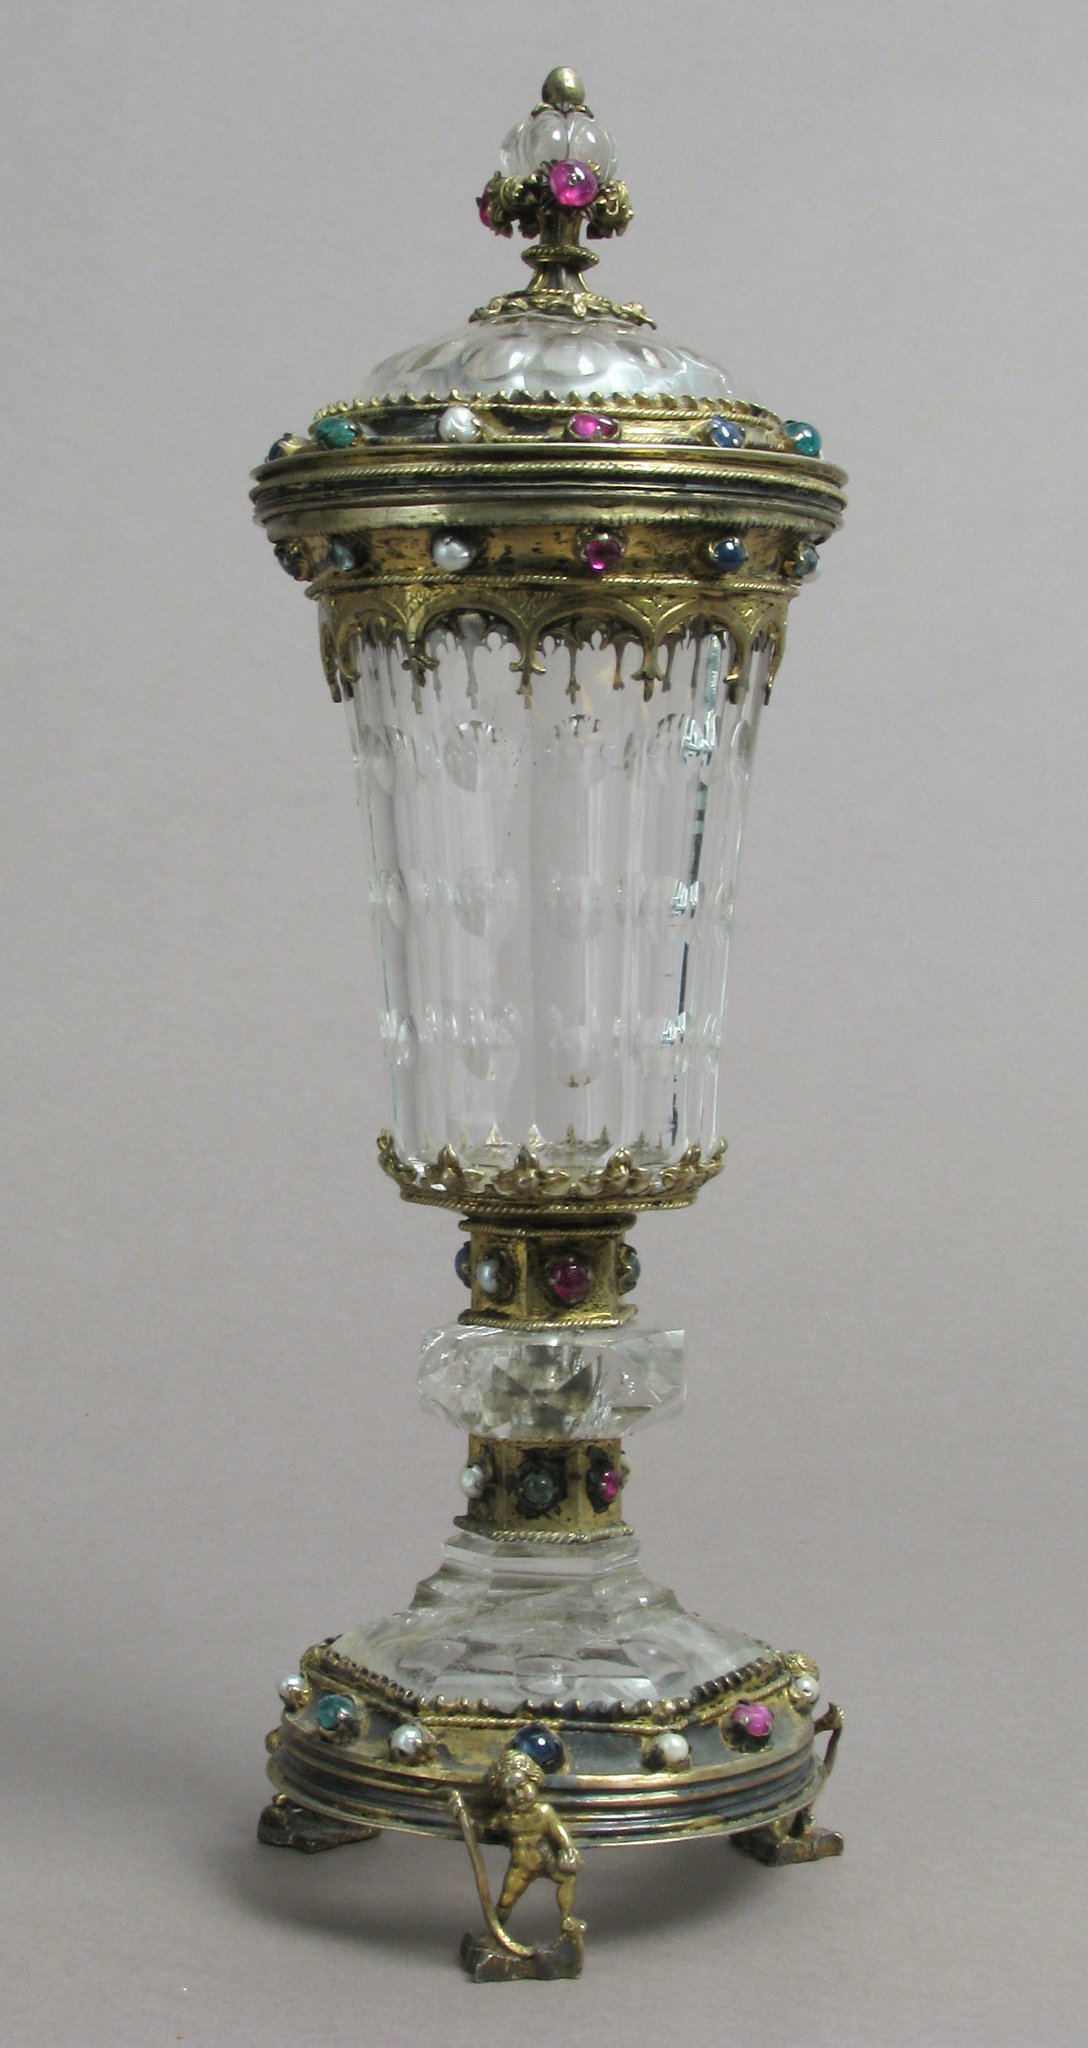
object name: cup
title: Covered Cup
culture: german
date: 1401-1500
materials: silver gilt, glass, pearl, quartz